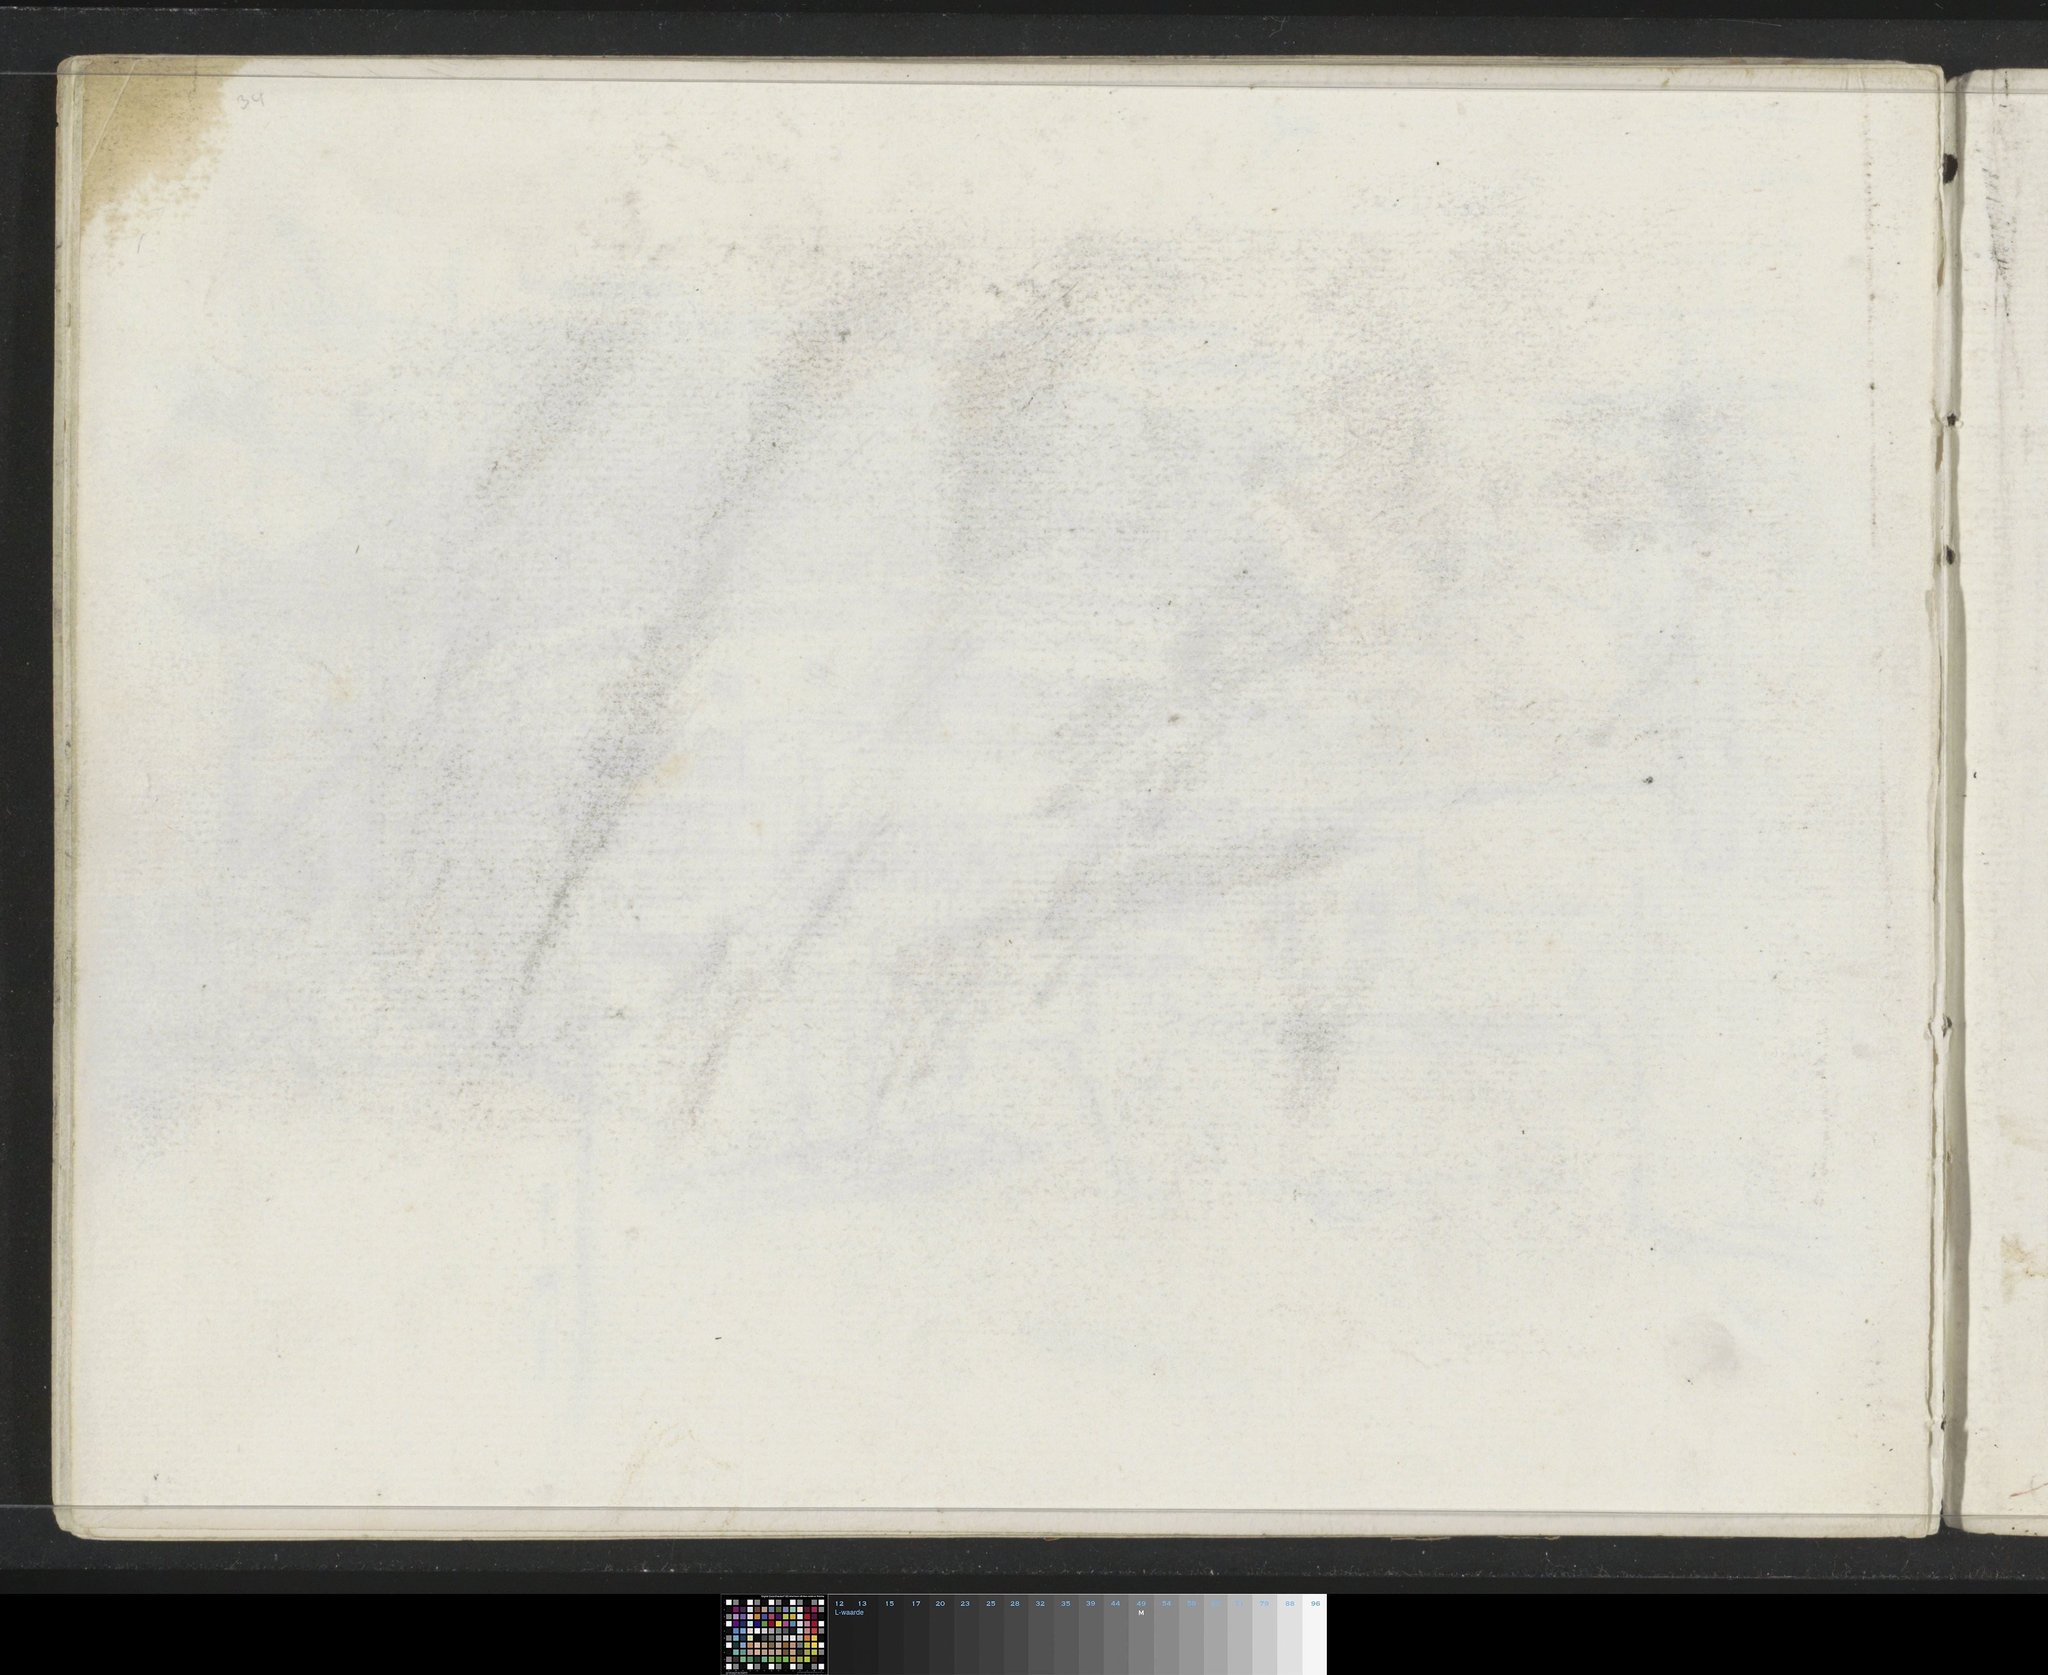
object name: sketchbook leaf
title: Abklatsch van een tekening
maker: willem witsen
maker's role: draughtsman, painter, print maker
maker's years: 1860-1923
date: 1910-1915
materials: paper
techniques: printmaking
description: Pagina 34 uit een schetsboek met 18 bladen.